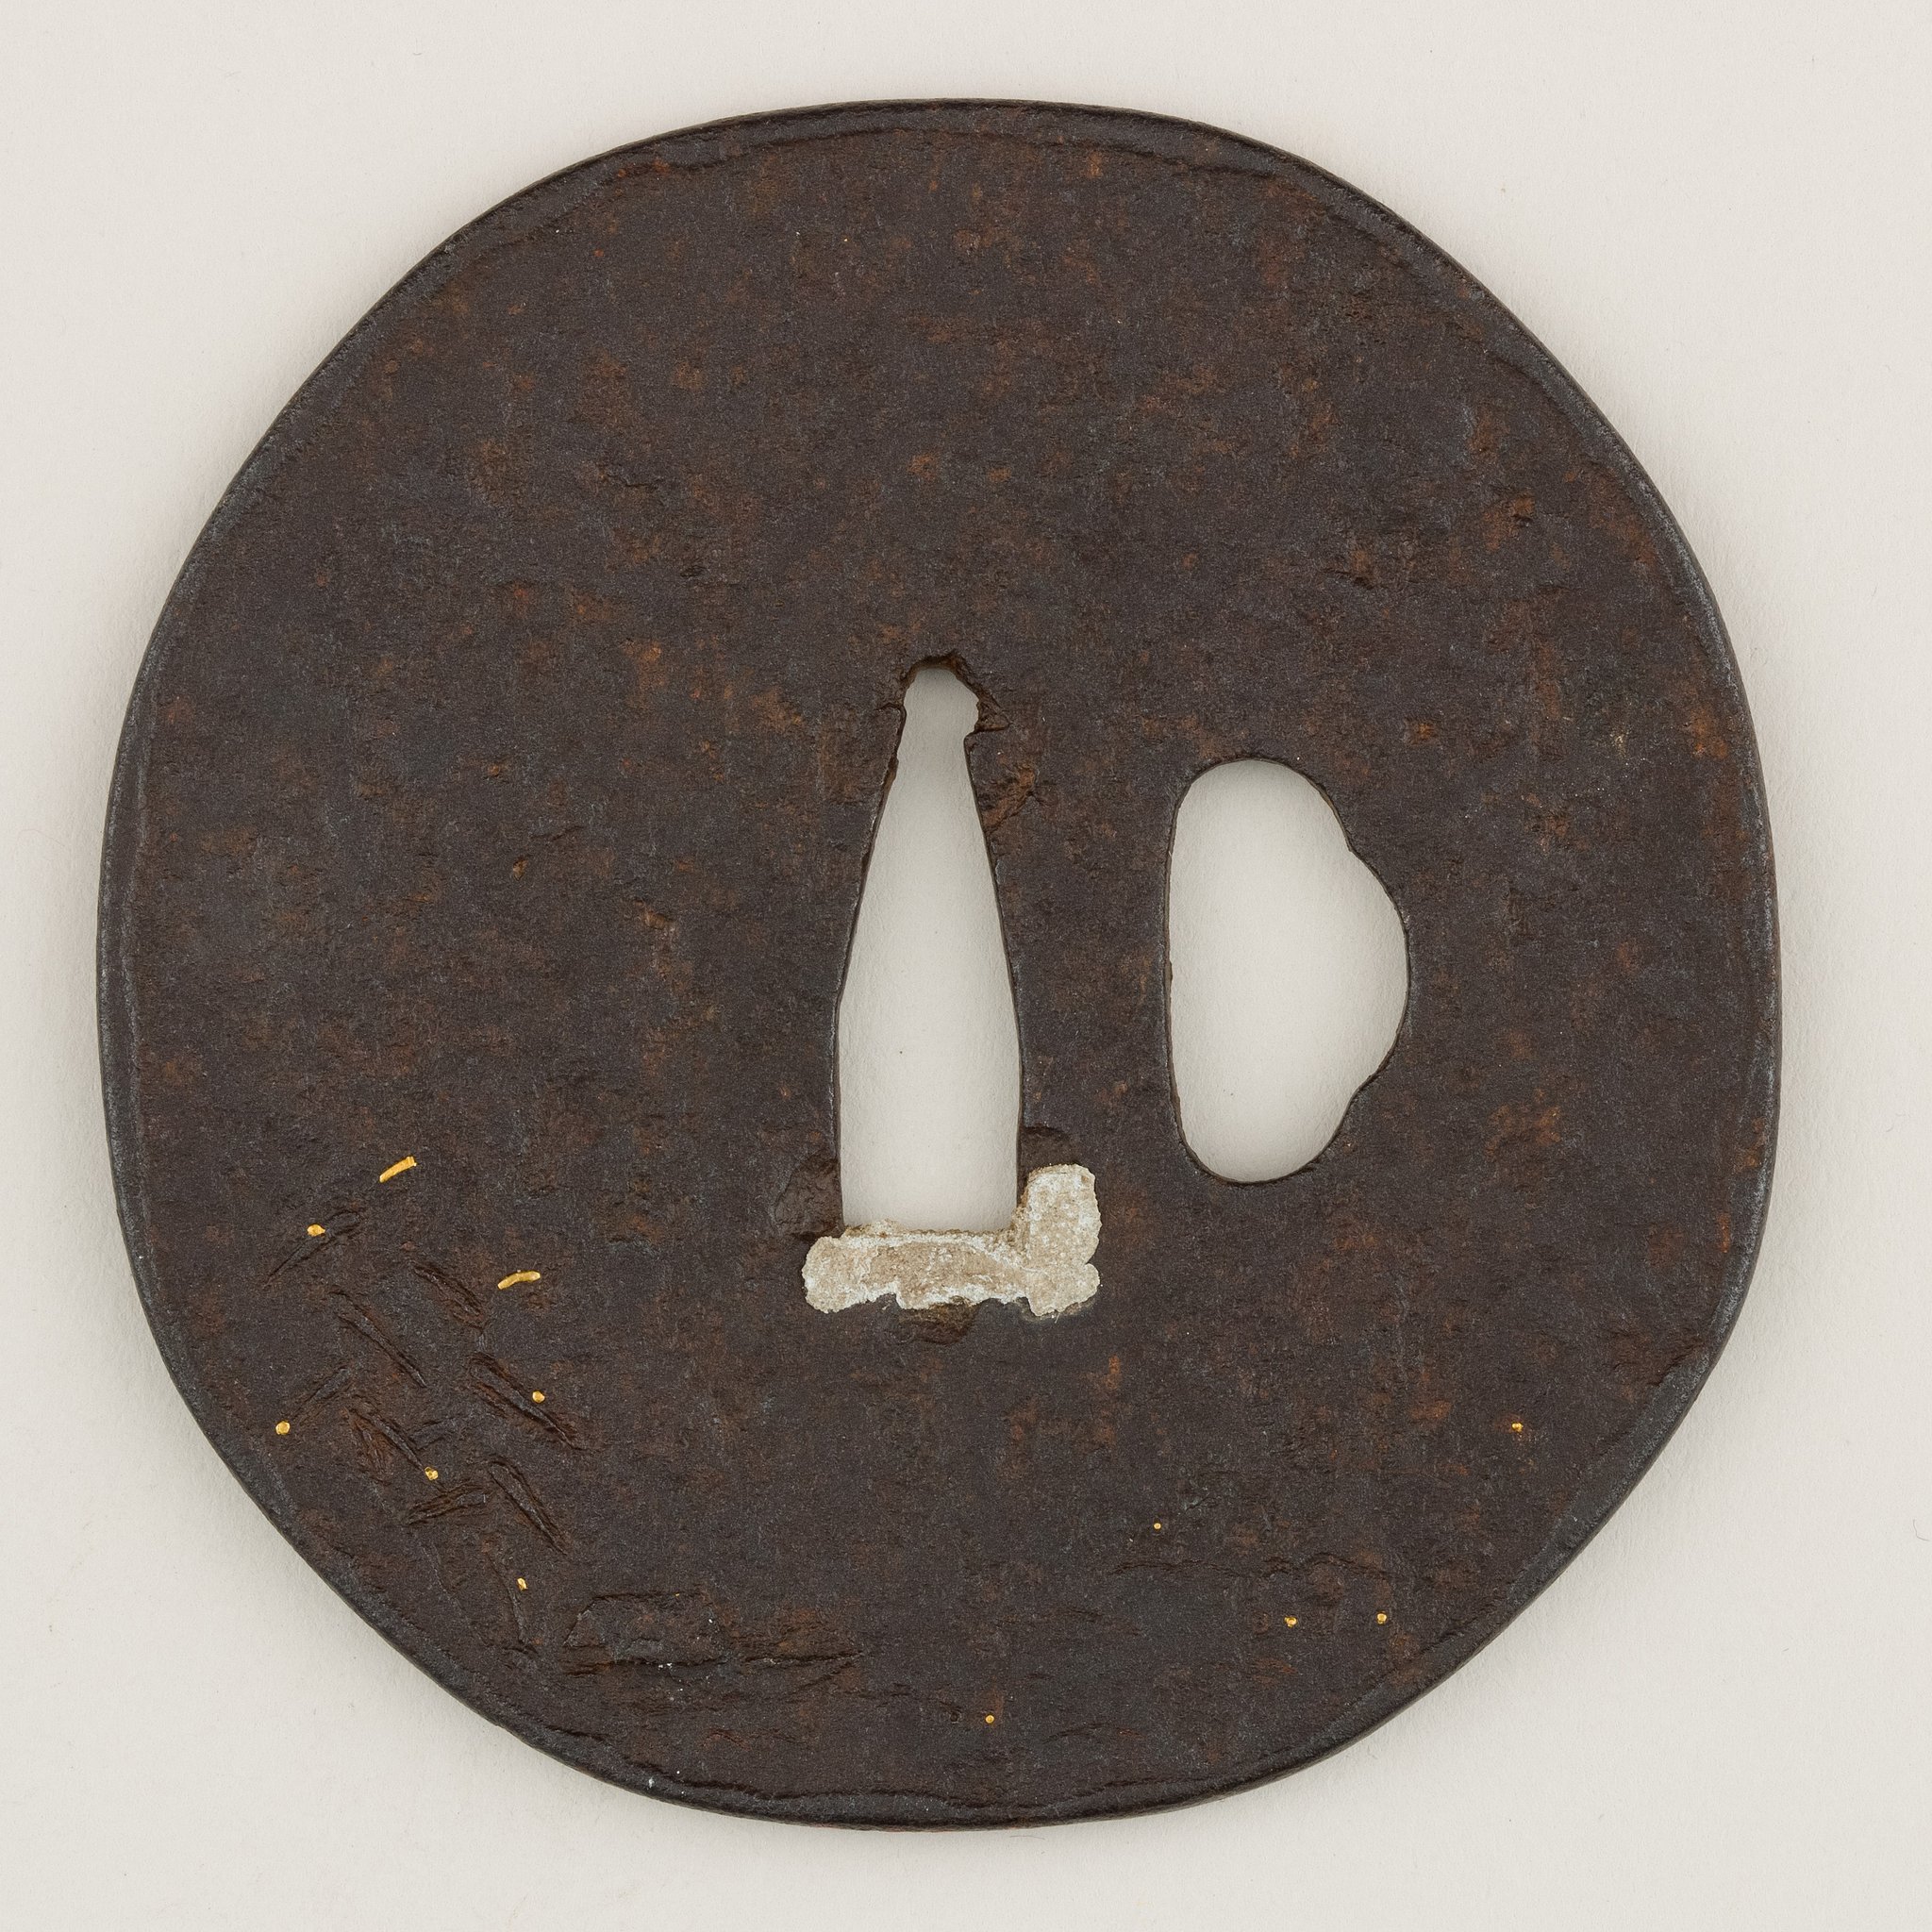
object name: sword guard tsuba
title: Sword Guard (Tsuba)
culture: japanese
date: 1501-1900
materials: gold, iron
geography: japan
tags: men